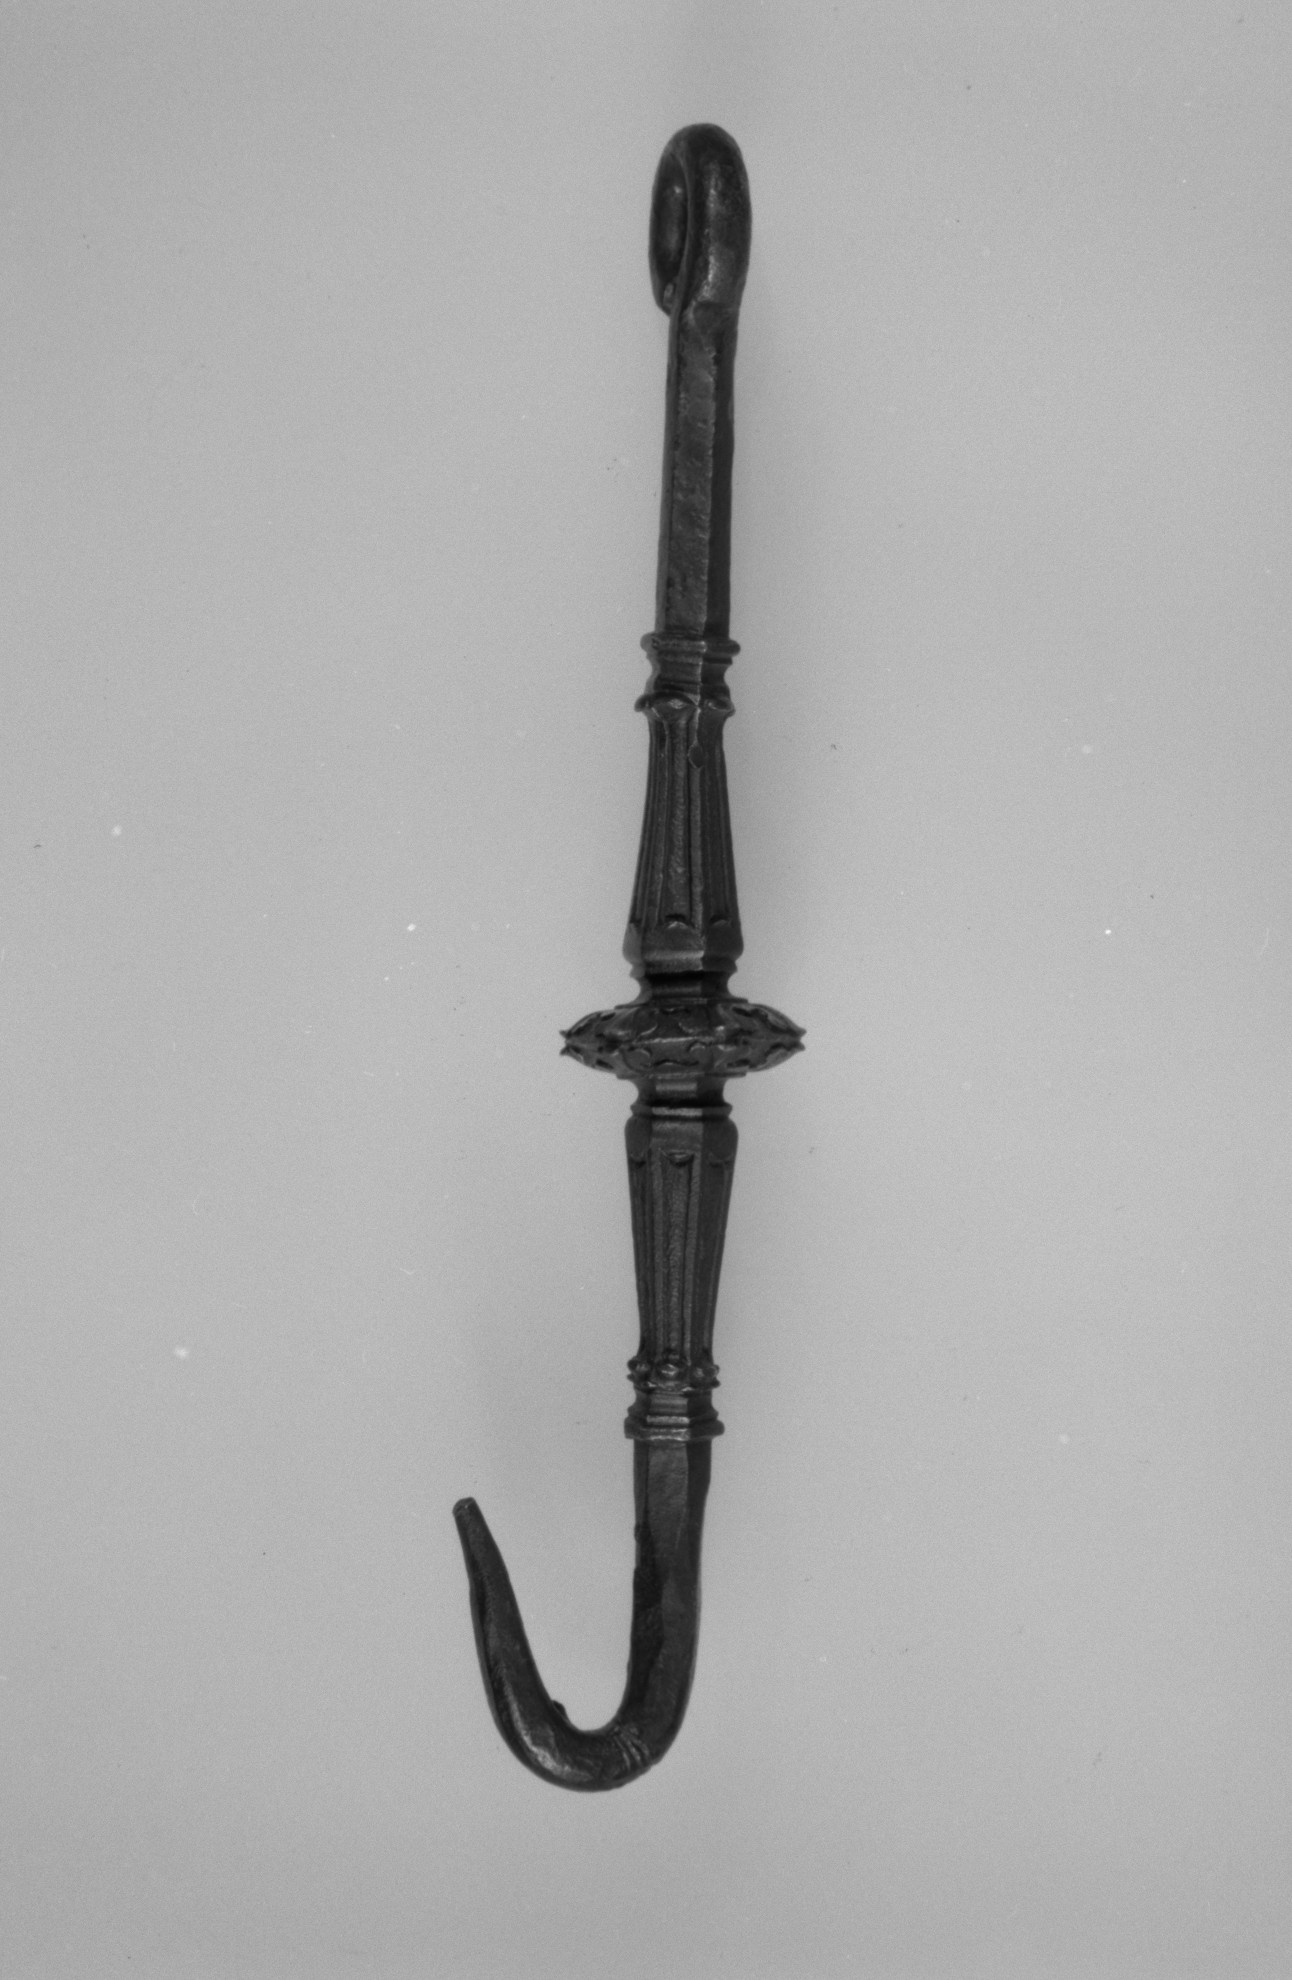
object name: hook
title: Pair of hooks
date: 1601-1700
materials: iron